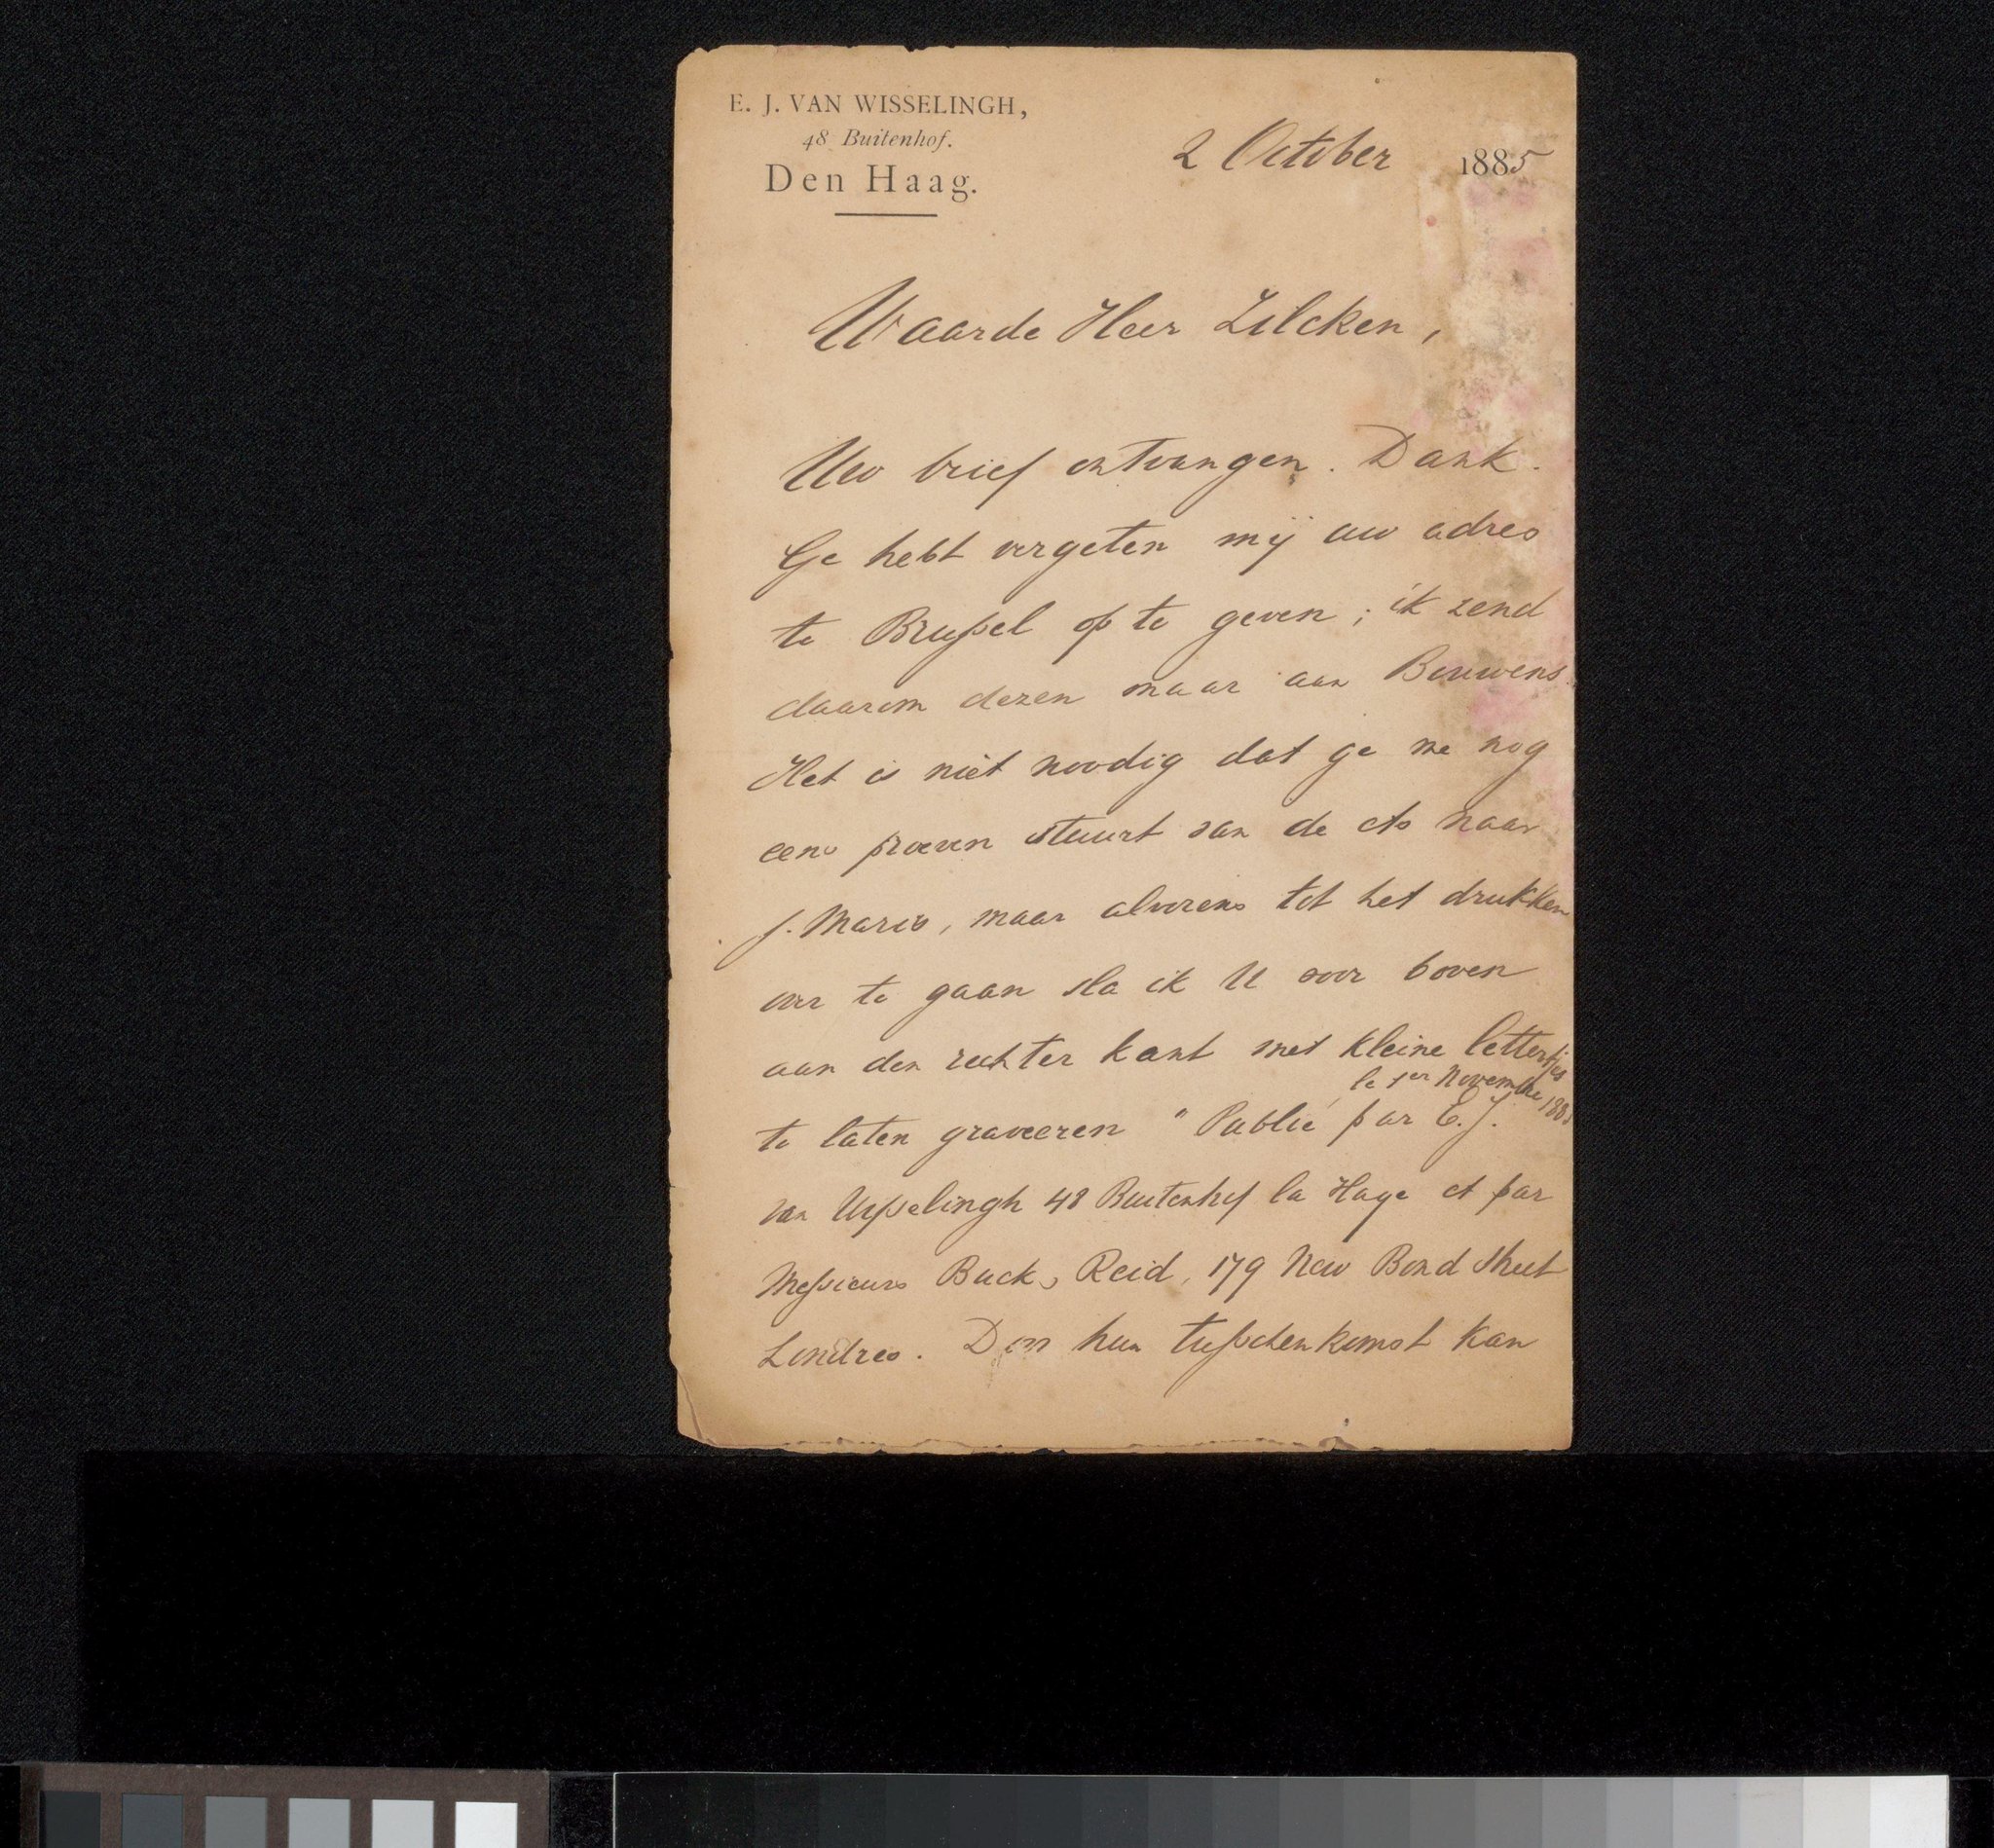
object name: letter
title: Brief aan Philip Zilcken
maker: elbert jan van wisselingh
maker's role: kunsthandelaar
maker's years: 1848-1912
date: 1885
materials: ink, paper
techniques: pen, printing, writing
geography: the hague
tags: print maker, draughtsman, jacob maris, joseph bouwens, philip zilcken, art trade, art shop, the graphic arts, the hague, london, brussels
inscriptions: collector's mark: ‘RPK’